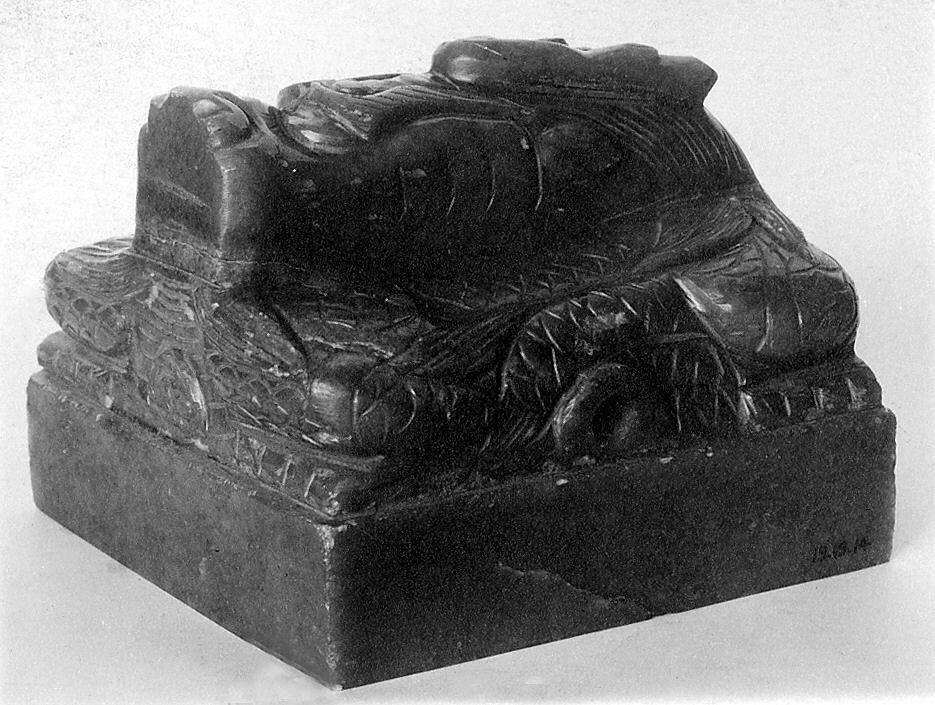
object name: seal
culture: chinese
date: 1368-1644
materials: jade